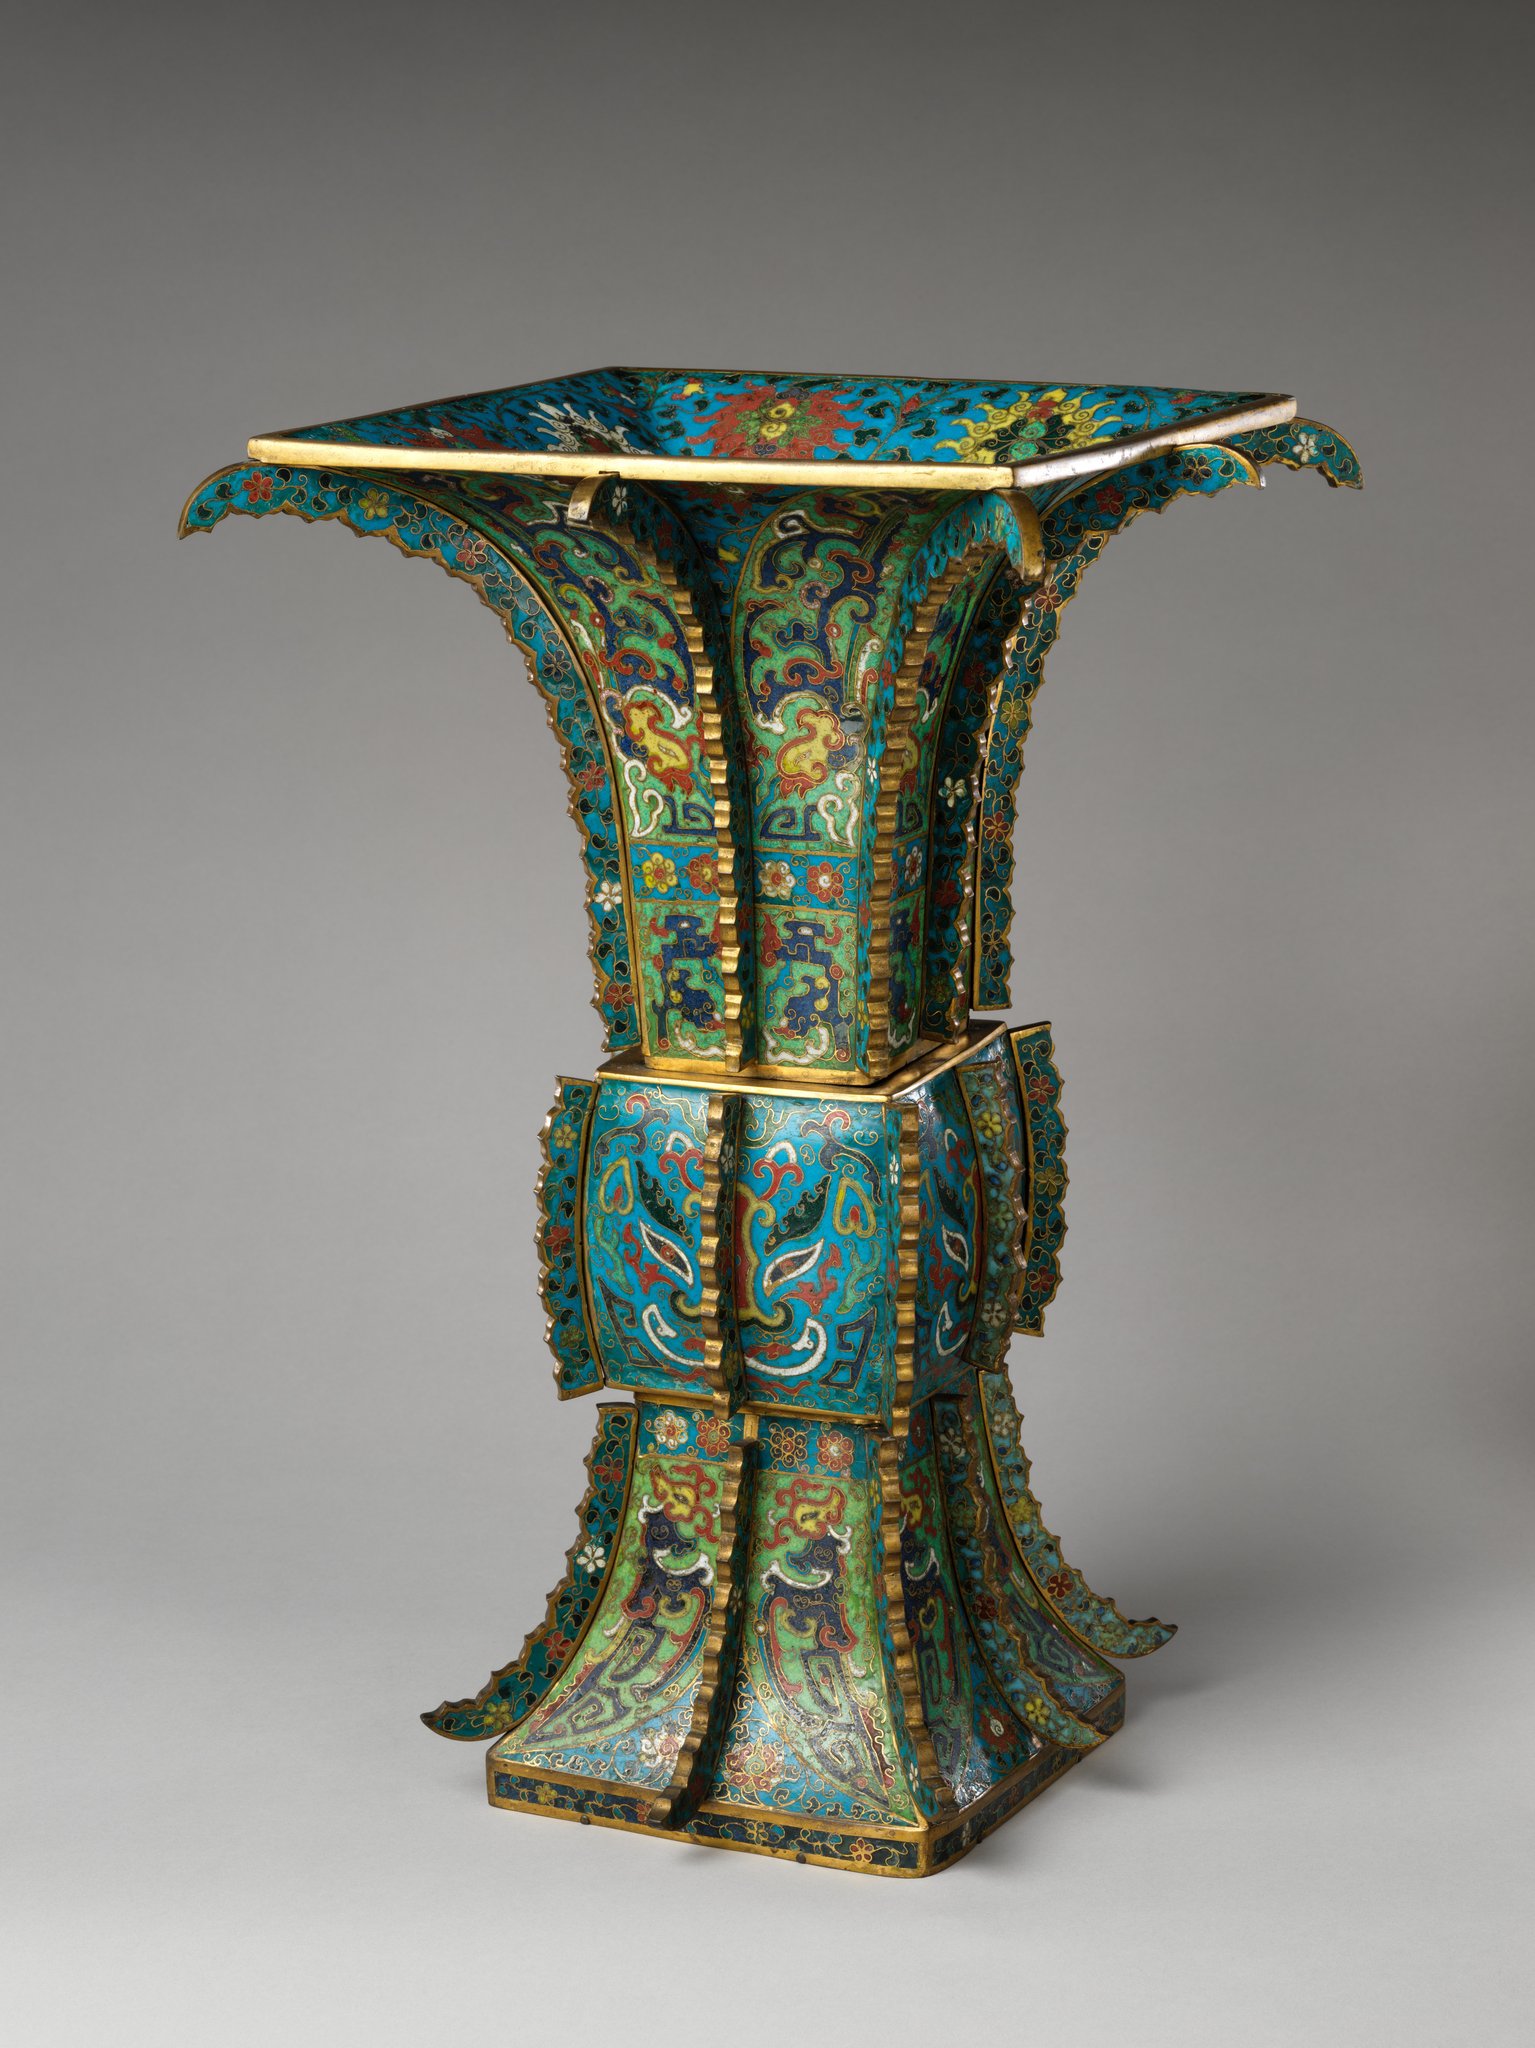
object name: vase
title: Vase in the form of an archaic wine vessel (fangzun)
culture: chinese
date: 1601-1700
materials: enamel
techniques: enamel